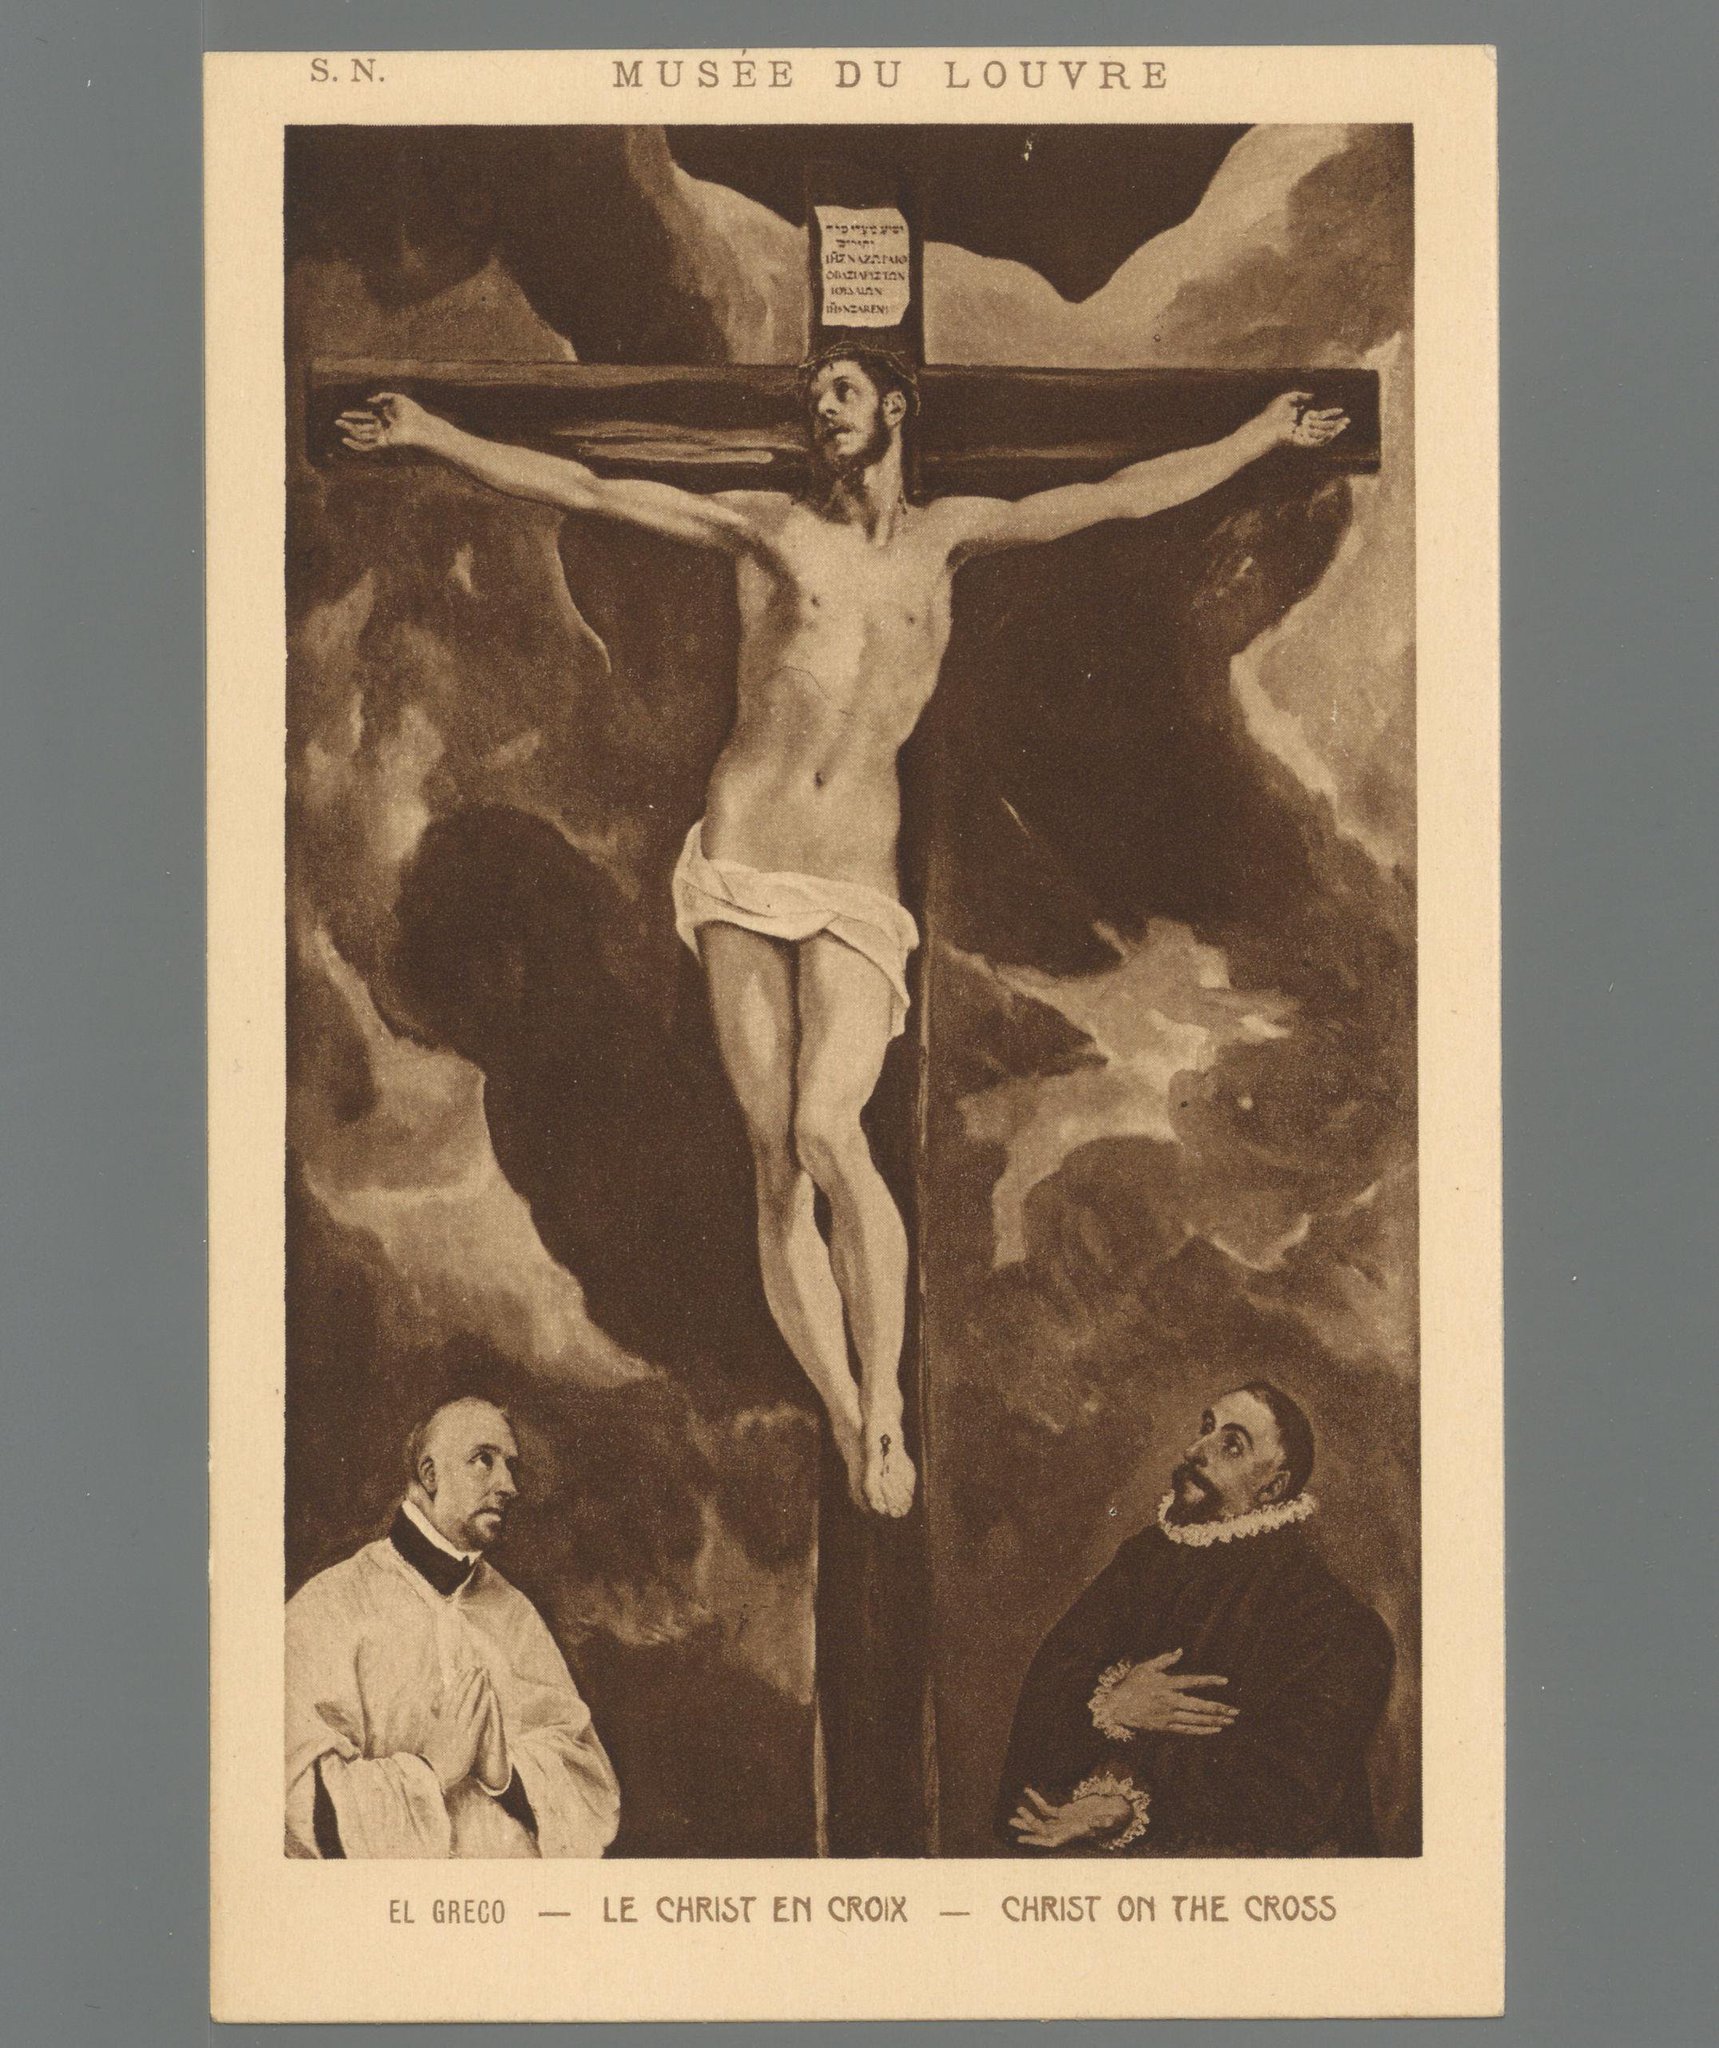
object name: photomechanical print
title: Musée du Louvre. El Greco - Le Christ en croix / Christ on the cross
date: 1903-1930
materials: cardboard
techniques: rotogravure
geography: paris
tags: permanent exhibition, museum, picture, painting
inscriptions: collector's mark: ‘AFE v S’